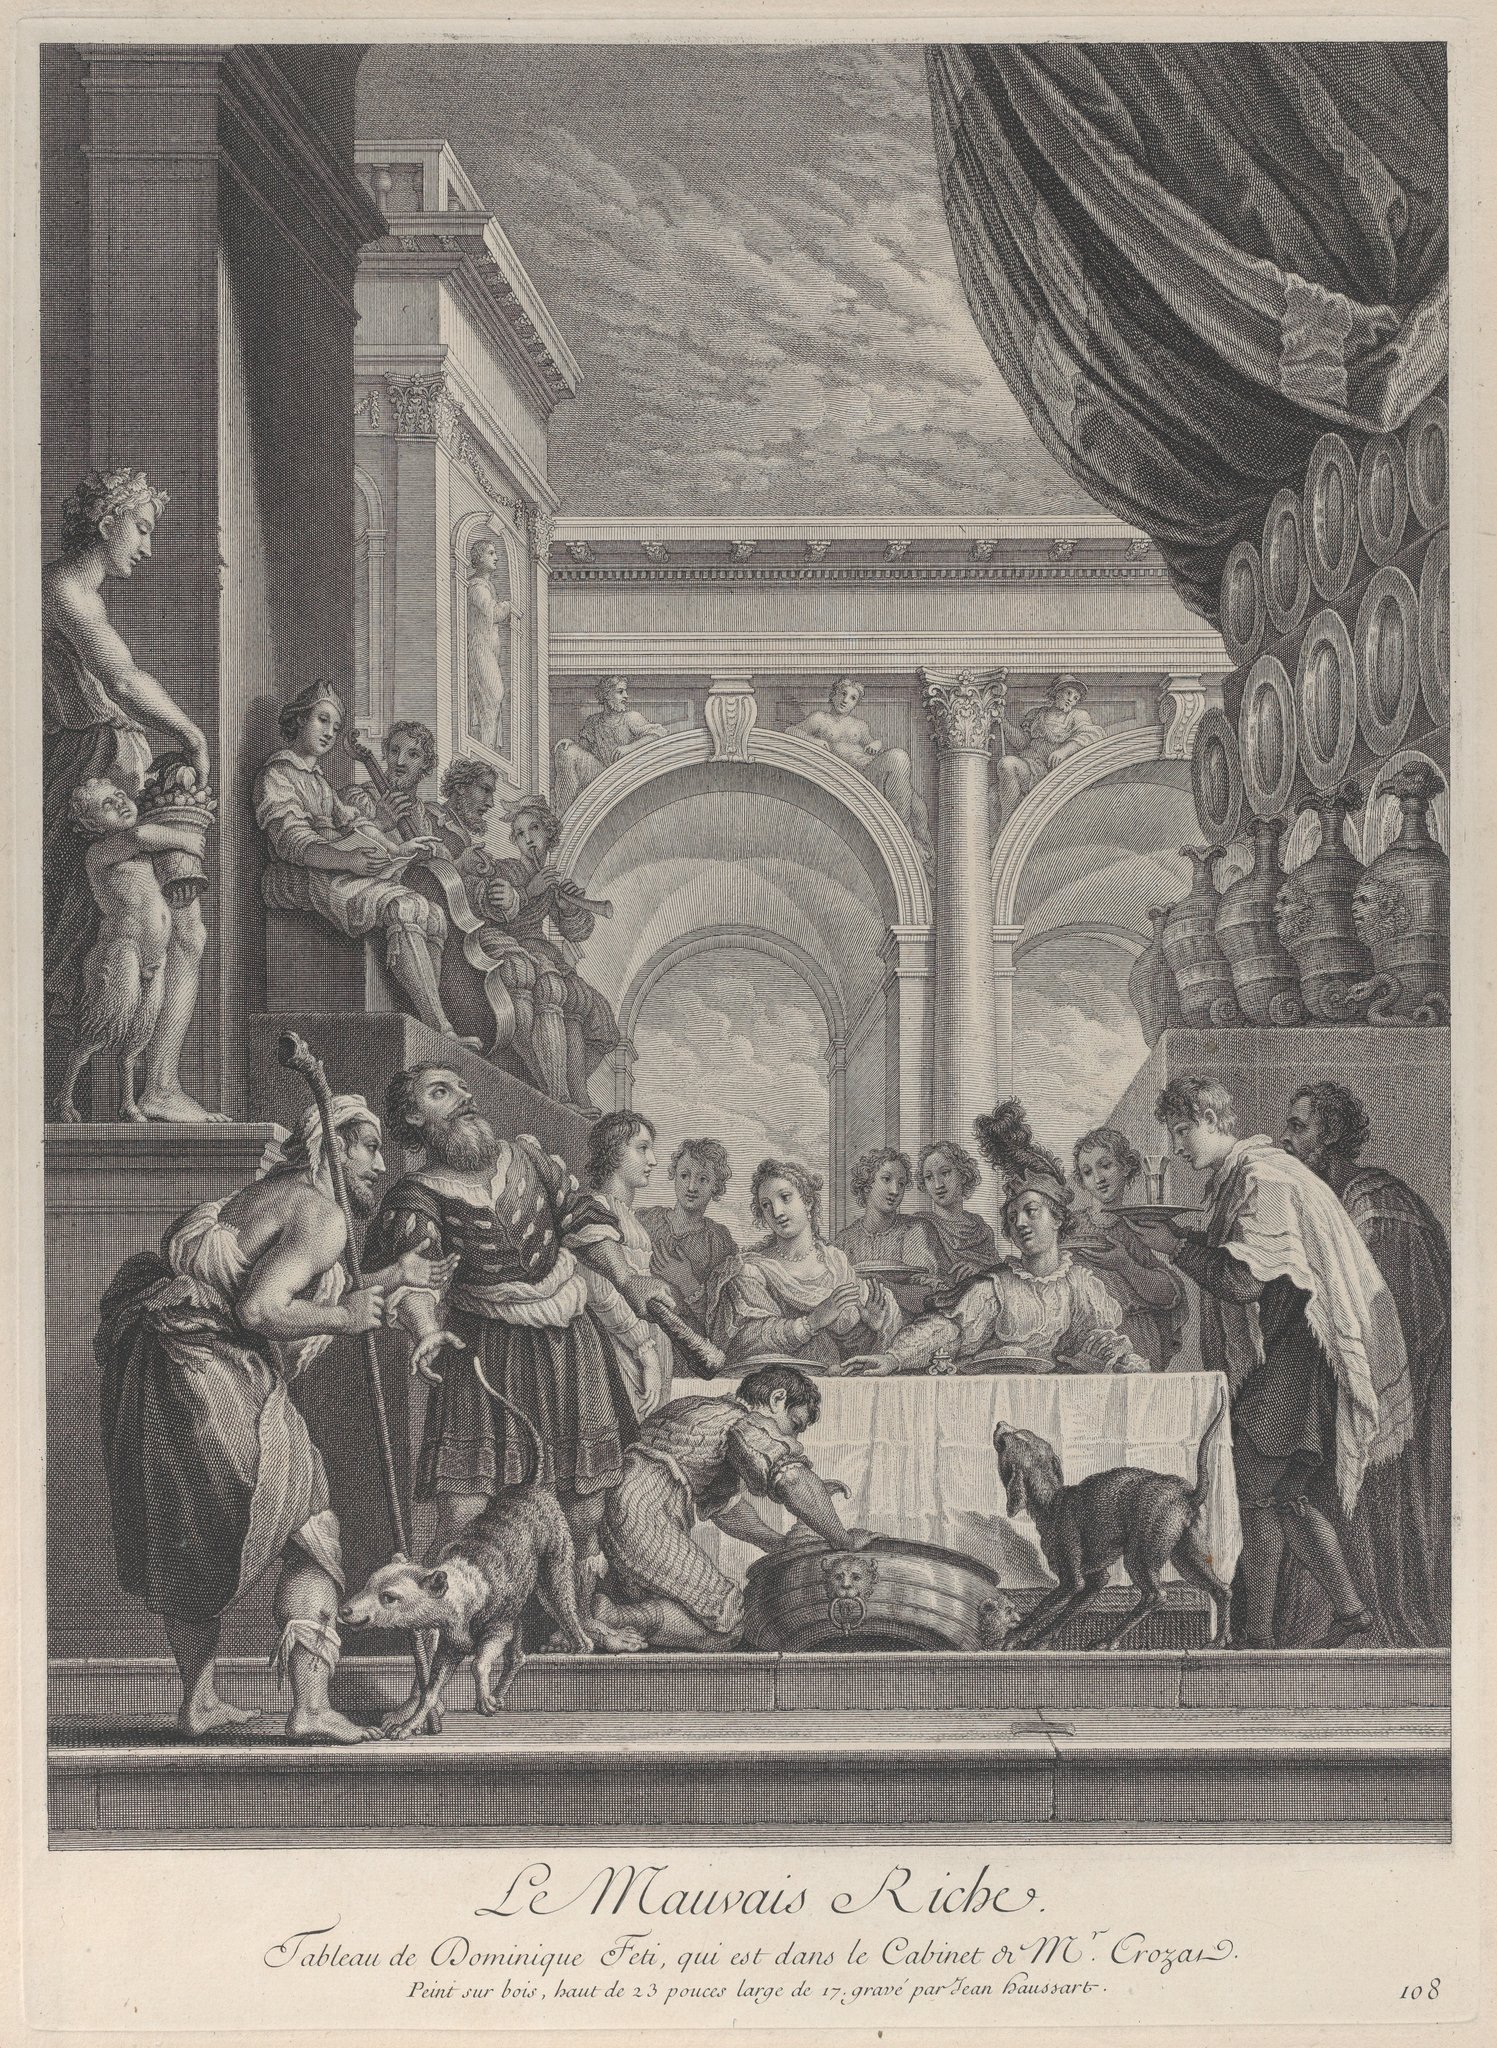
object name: print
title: Parable of Lazarus and Dives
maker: jean-baptiste haussard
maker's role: artist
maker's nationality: french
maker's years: 1679-1749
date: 1729-1740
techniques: engraving, etching